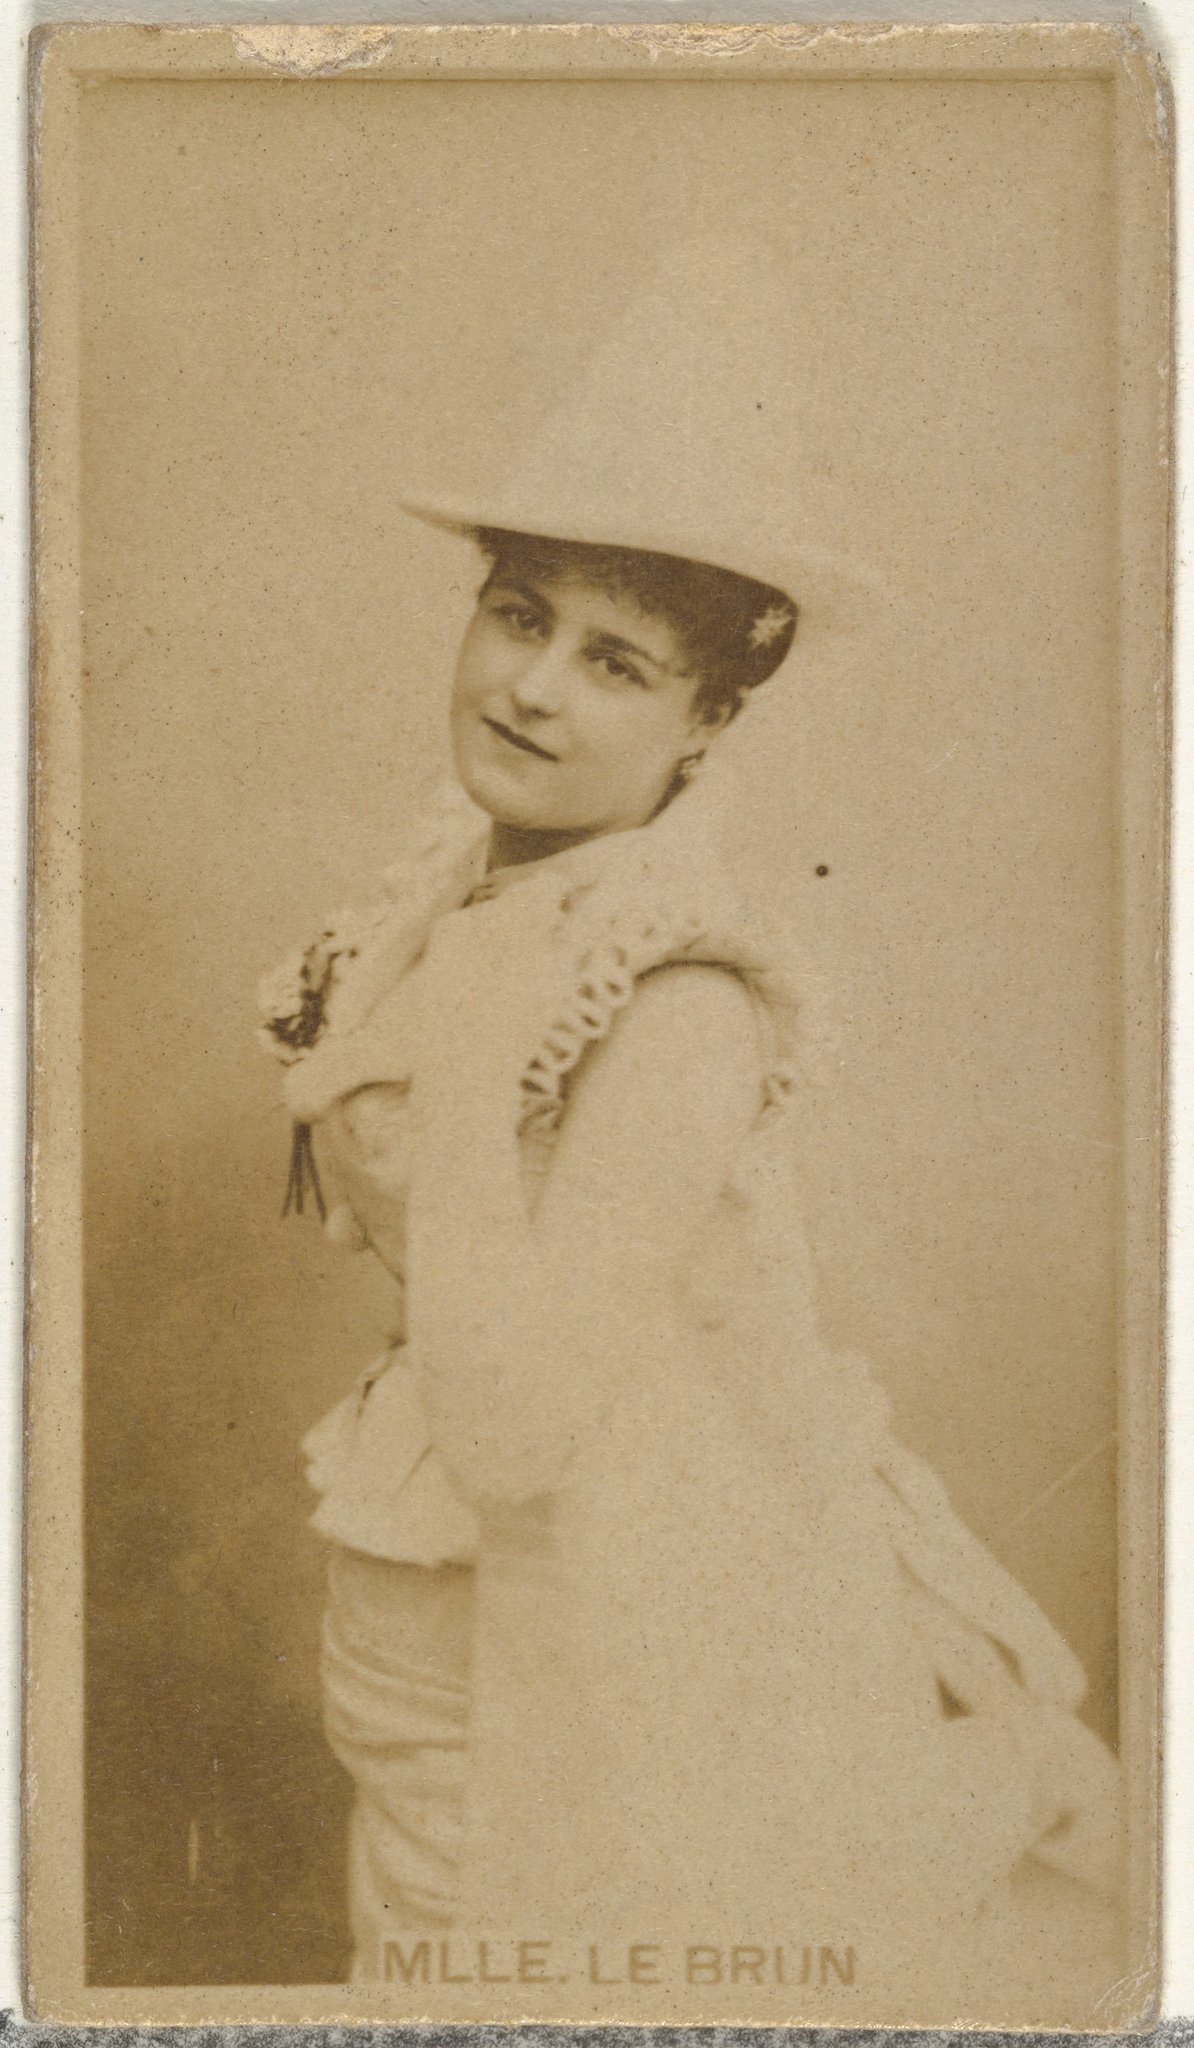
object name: photograph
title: Mlle. Le Brun, from the Actors and Actresses series (N145-8) issued by Duke Sons & Co. to promote Duke Cigarettes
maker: w. duke, sons & co.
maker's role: publisher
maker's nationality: american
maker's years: 1870-1920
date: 1891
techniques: albumen silver print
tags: portraits,women,actresses